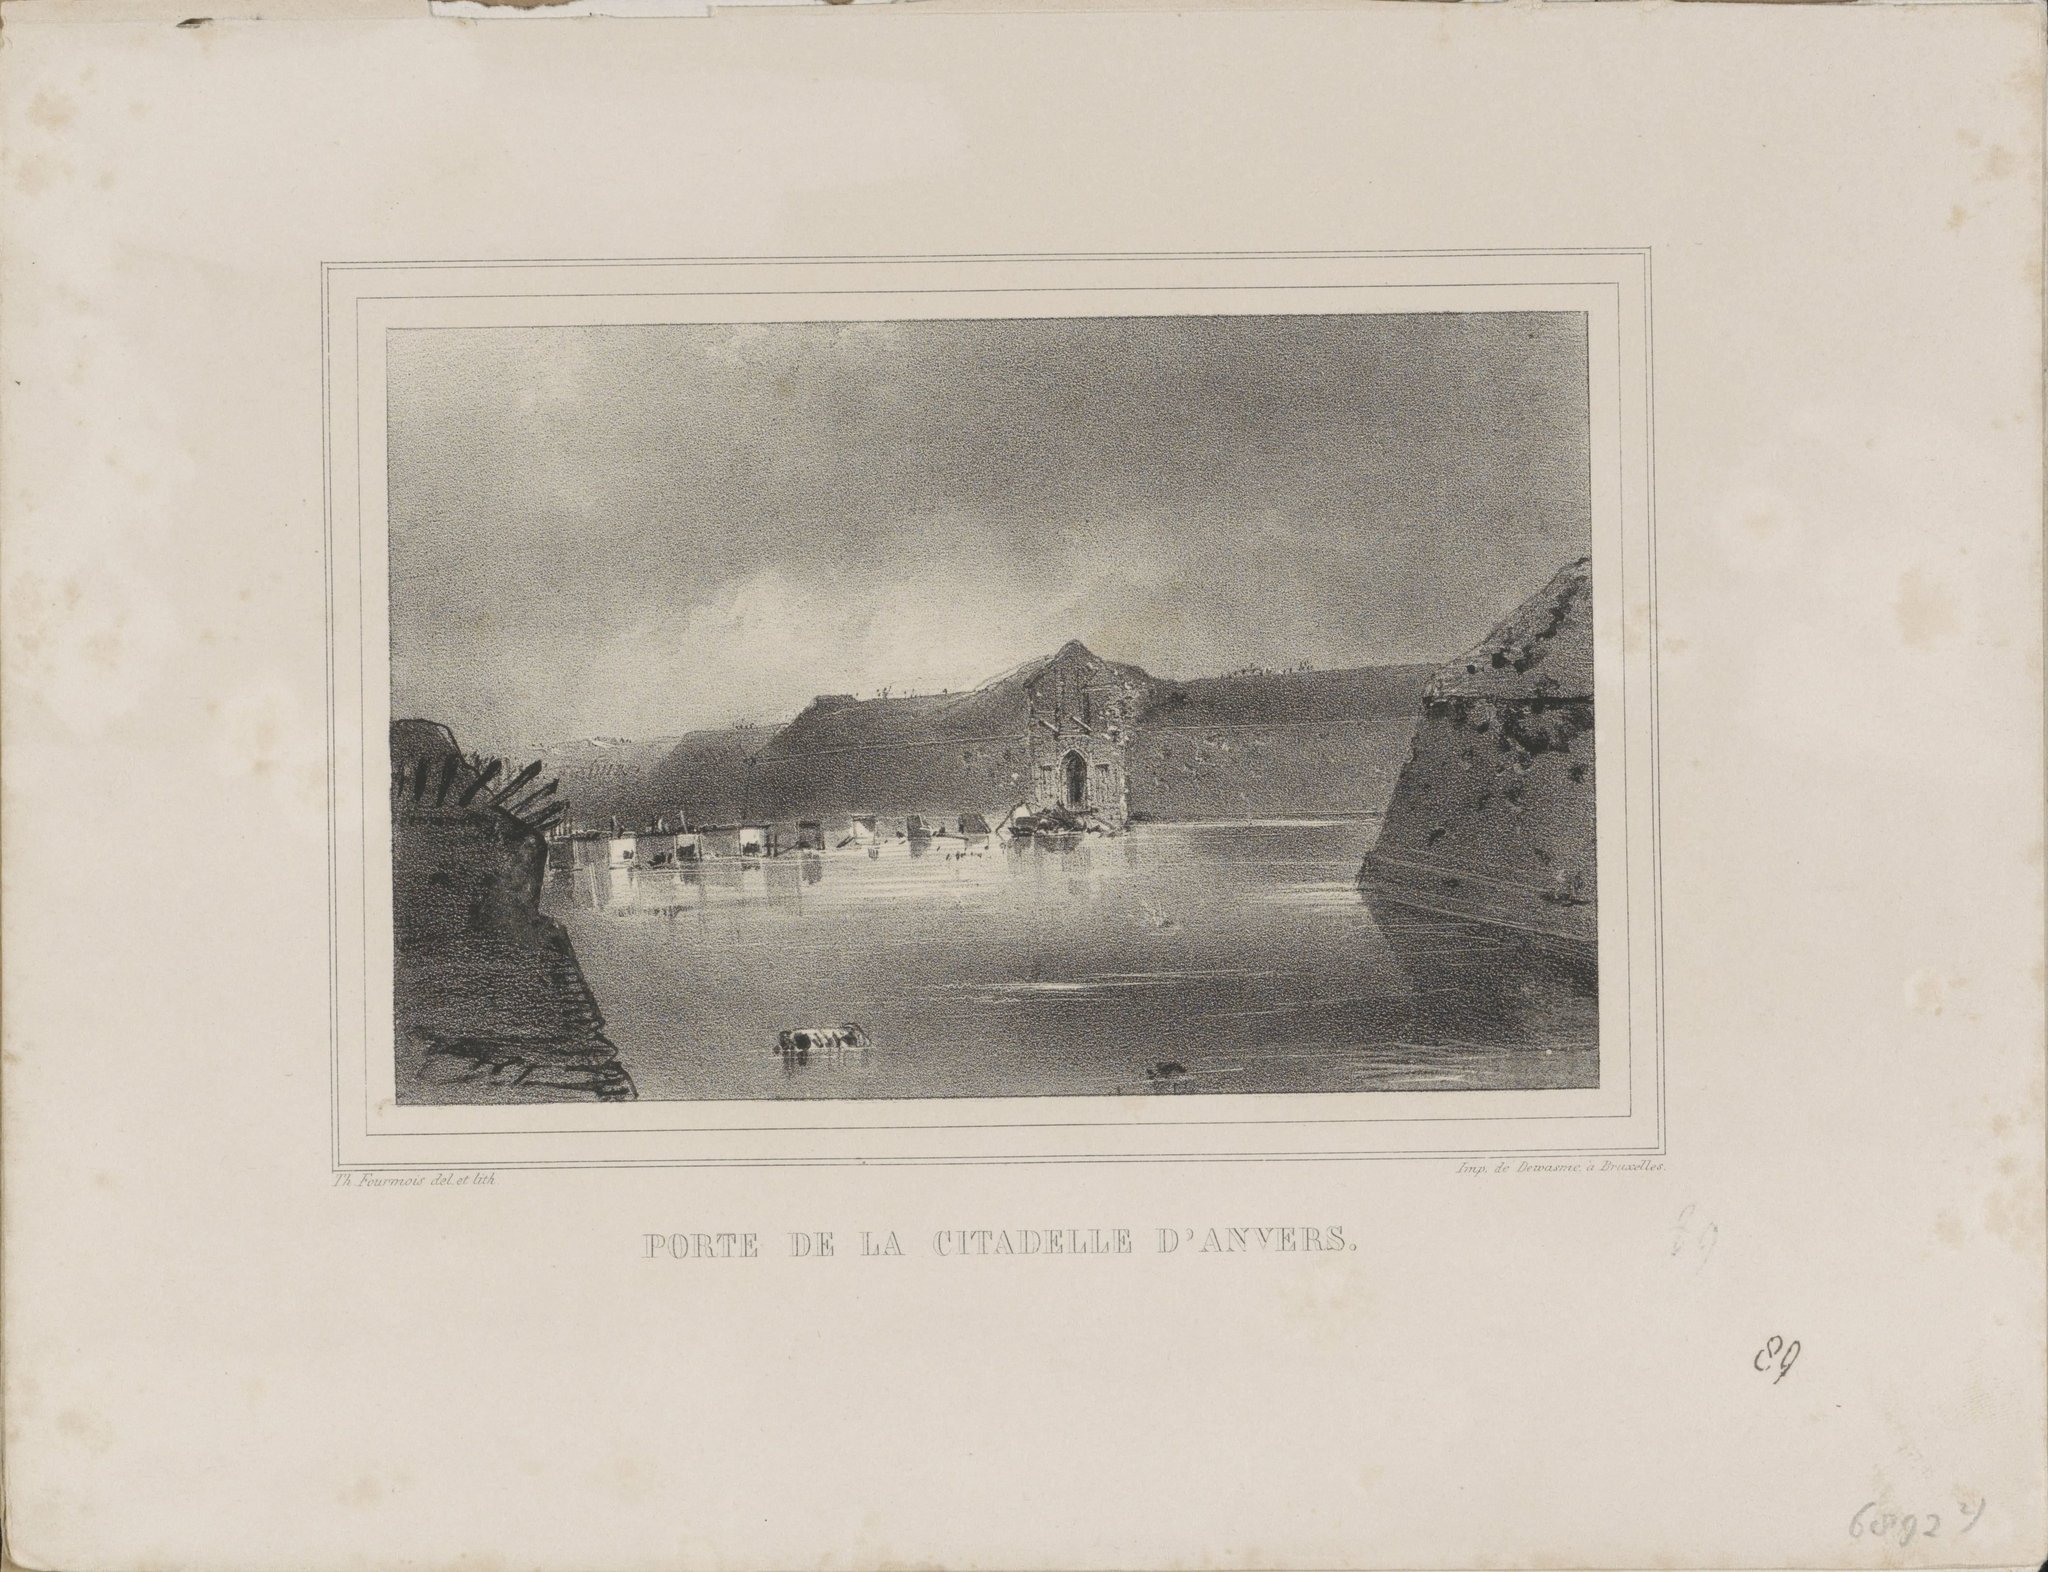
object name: print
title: Poort van de Citadel van Antwerpen, 1833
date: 1833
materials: paper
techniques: lithograph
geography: brussels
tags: permanent fortifications, devastated, ruined place or city (~ warfare)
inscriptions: collector's mark: Lugt 2228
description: De ingangspoort naar de Citadel van Antwerpen in 1833. Het terrein tussen de vestingmuren staat onder water. Onderdeel van een serie van zes platen uit 1833 van de ruïnes van de citadel na het beleg door het Franse leger in november en december 1832.